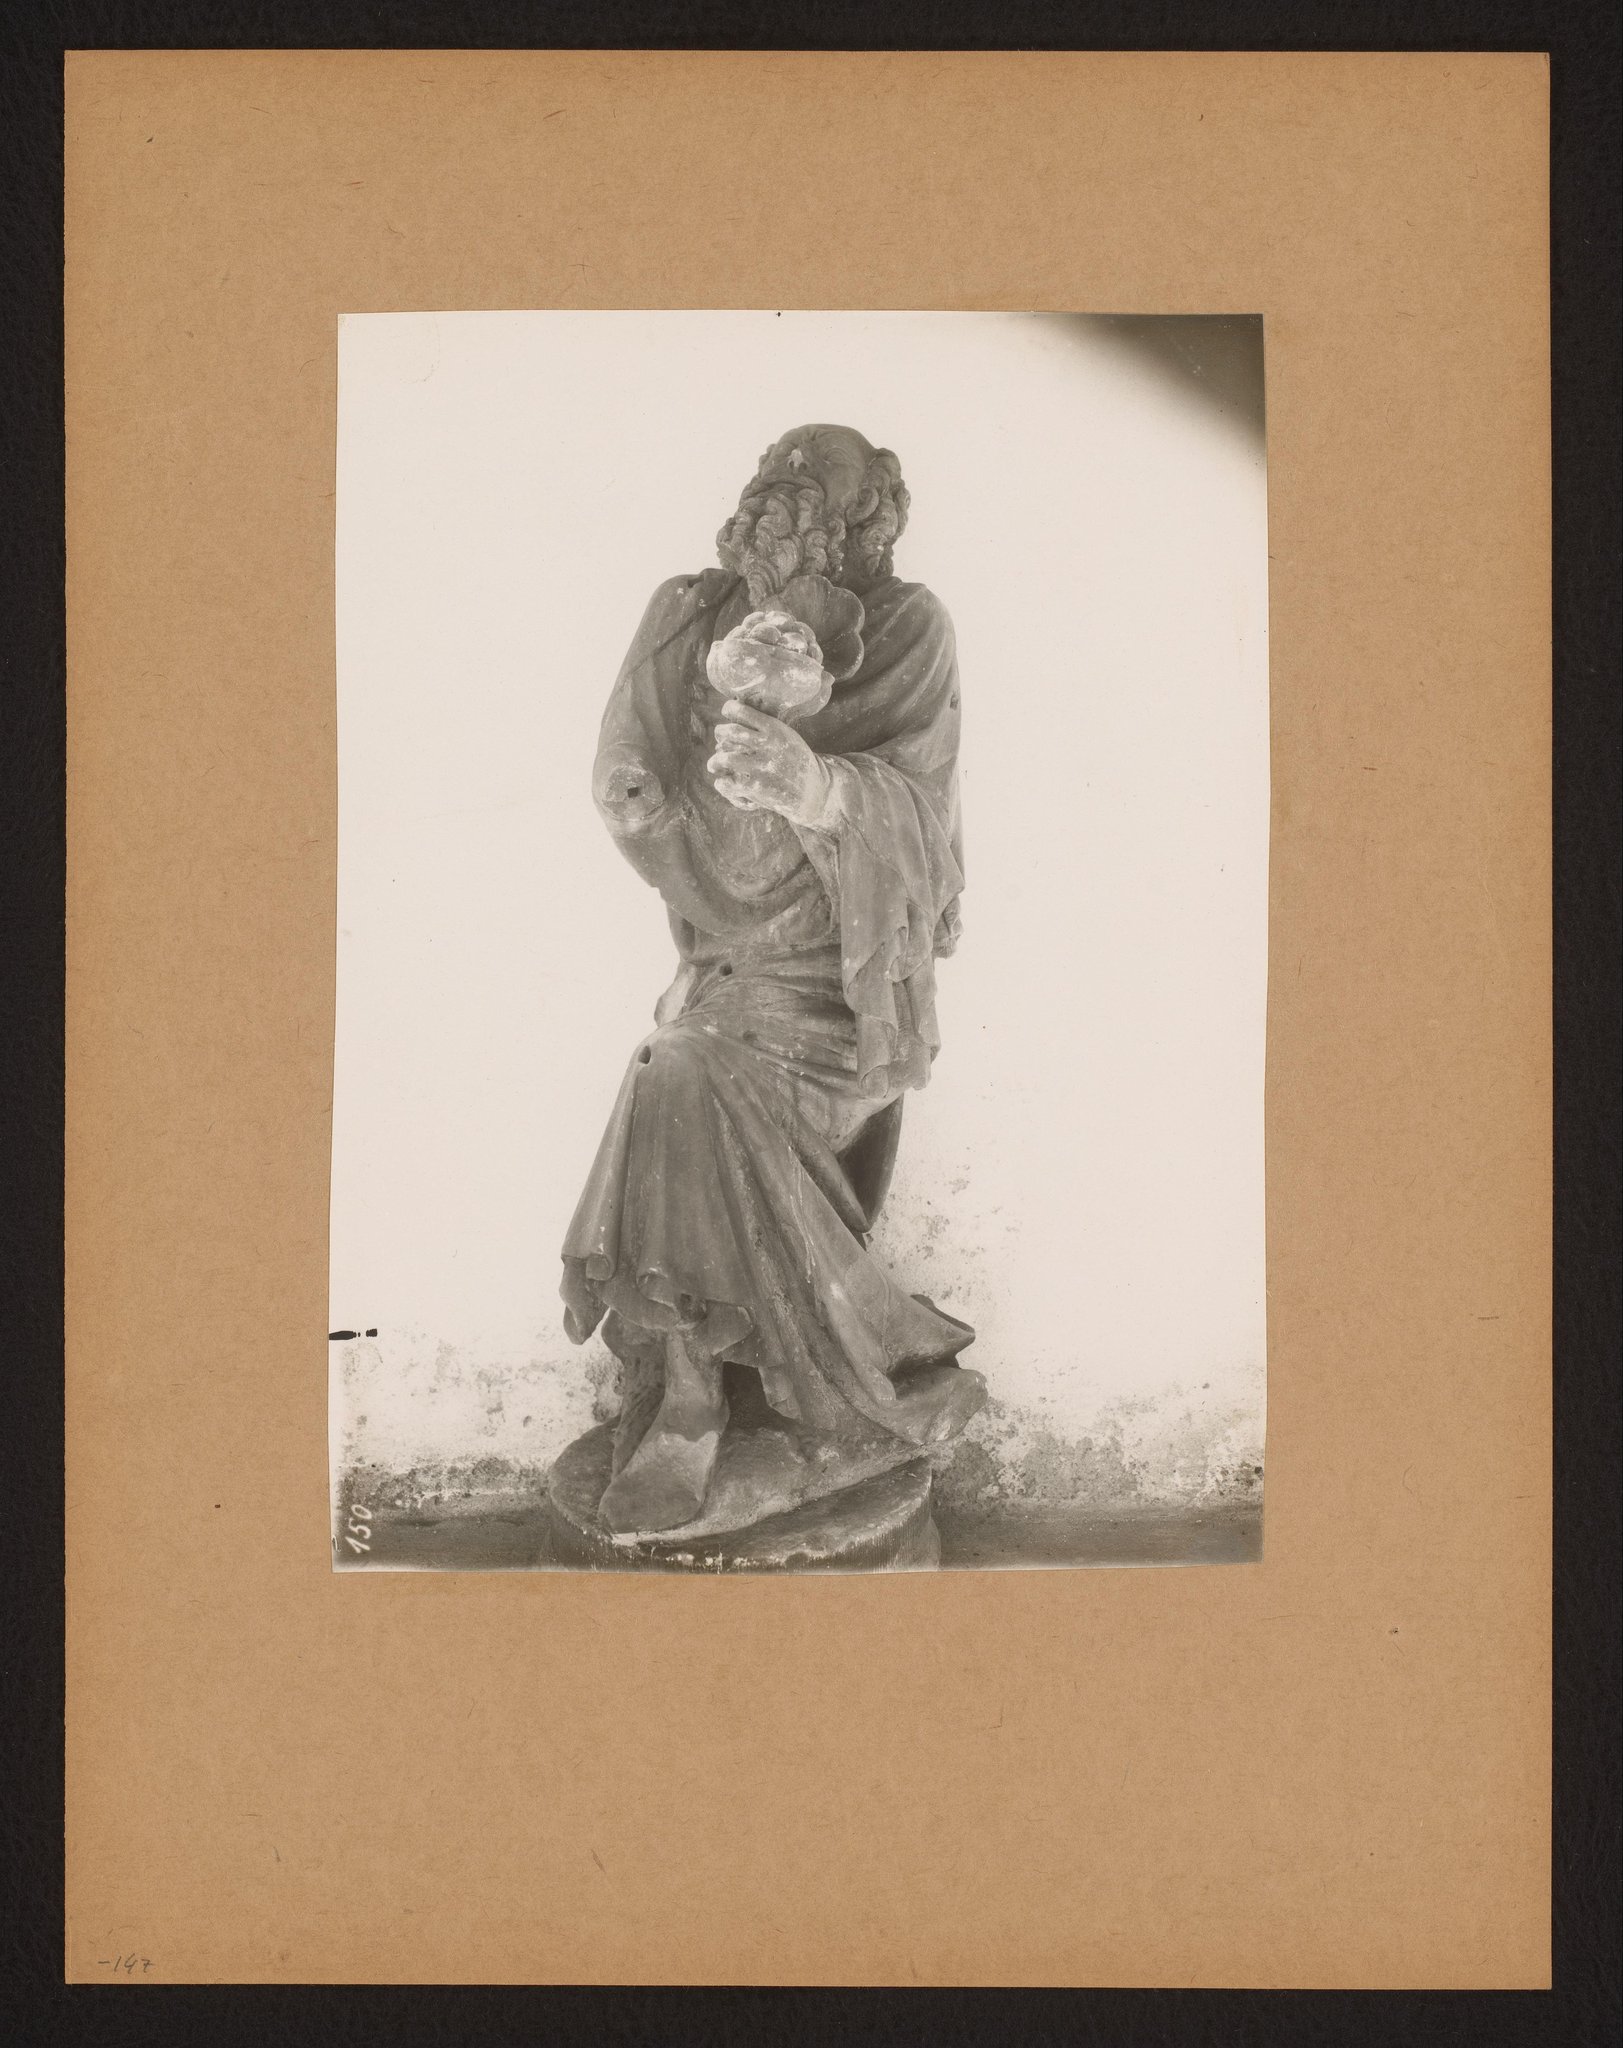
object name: album leaf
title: Beeldhouwkunst in de kloostergang van de dom van Bamberg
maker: Anonymous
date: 1900-1920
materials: paper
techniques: gelatin silver print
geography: bamberg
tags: interior of church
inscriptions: number: ‘150’